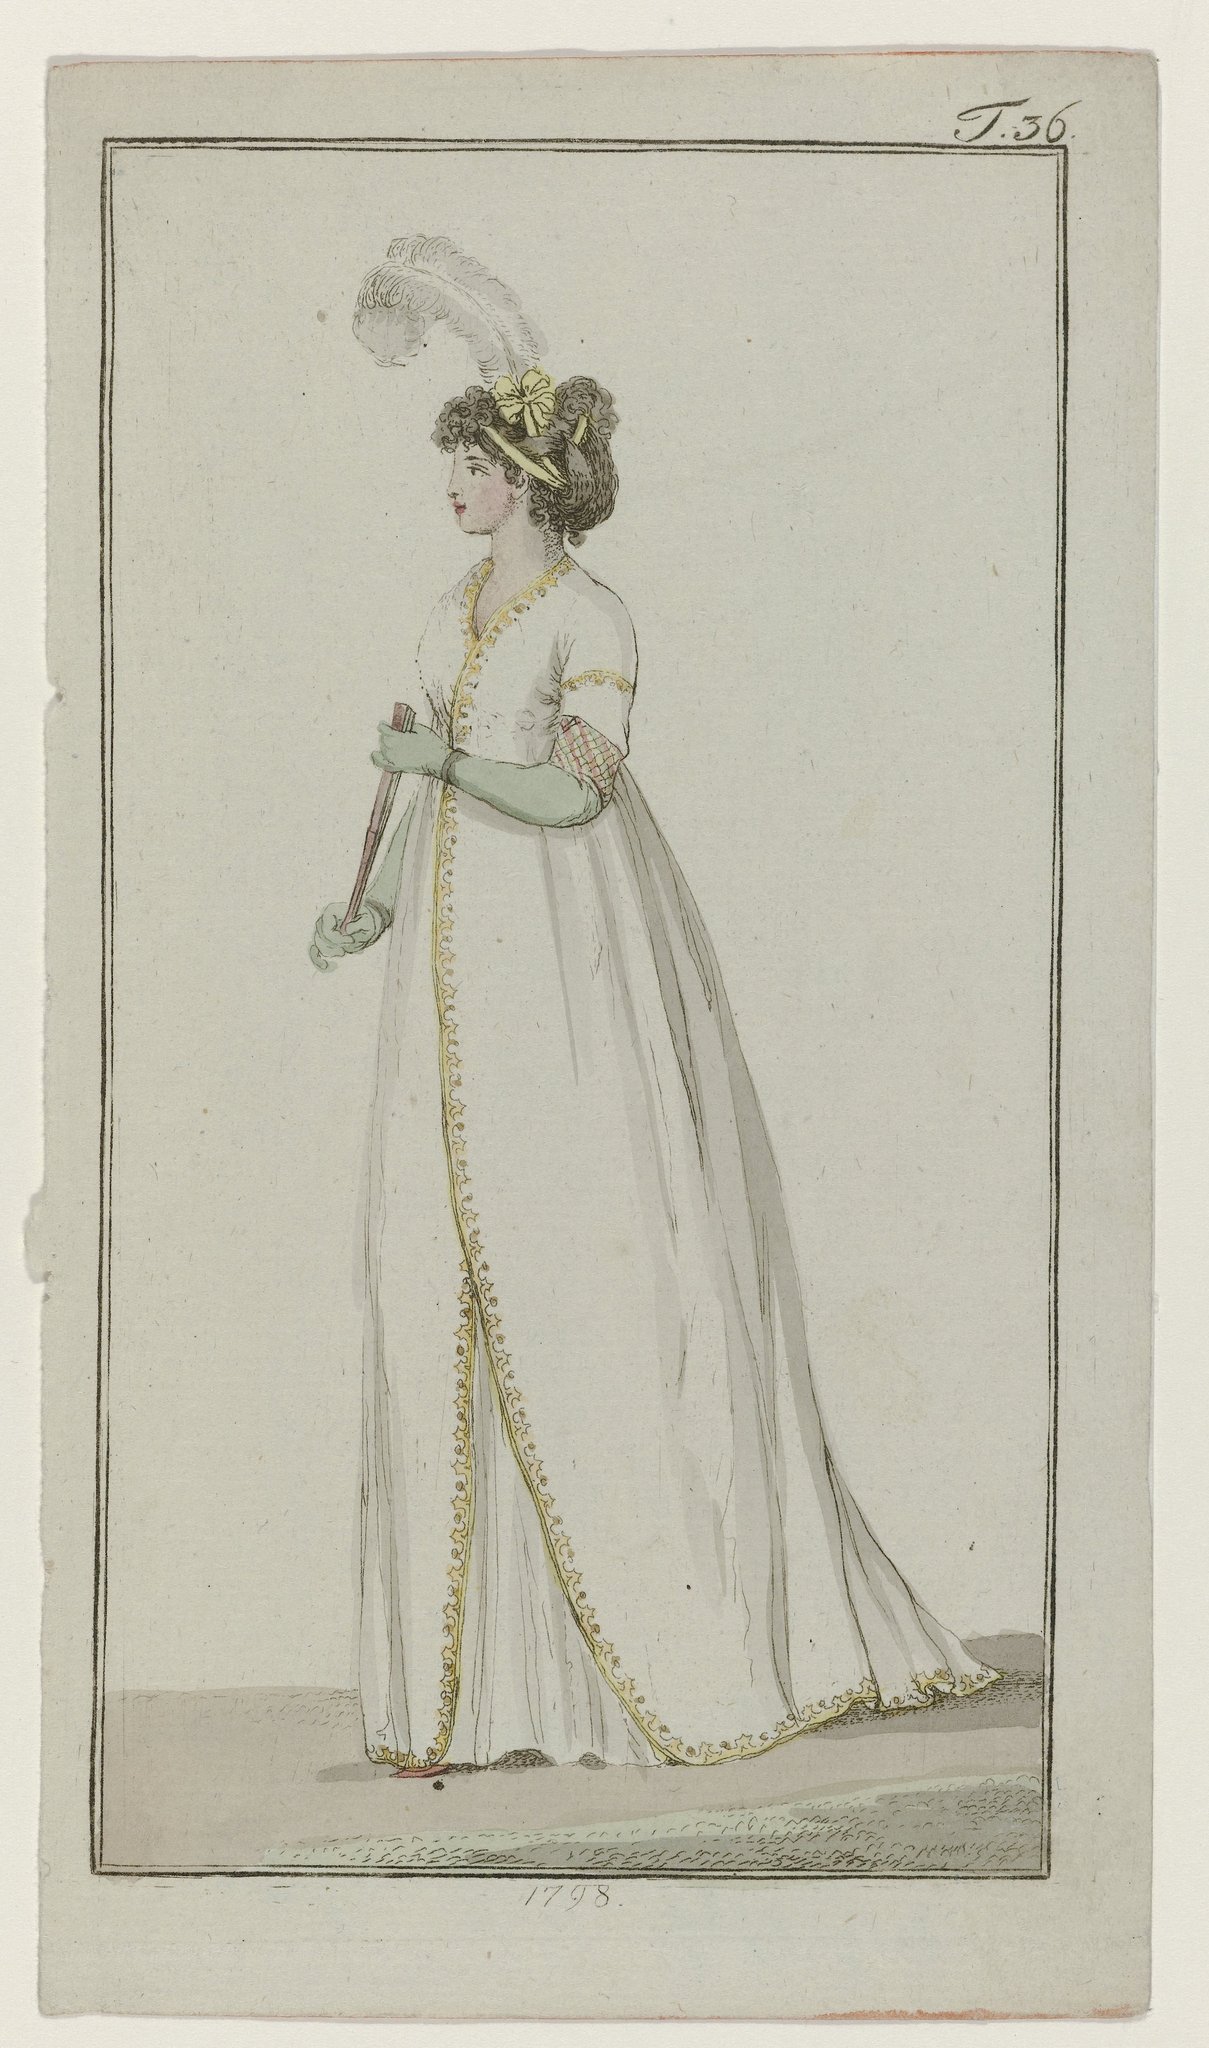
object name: fashion print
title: Journal des Luxus und der Moden, 1798, T 36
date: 1798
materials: paper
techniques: etching, hand coloring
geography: weimar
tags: diadem, tiara (+ women's clothes), gloves, mittens (long gloves) (+ women's clothes), fashion plates, shoes, sandals (+ women's clothes), dress, gown (+ women's clothes), fan (+ women's clothes), bracelet, wristlet (+ women's clothes)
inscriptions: date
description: Vrouw in een japon met overslag, korte mouwen en sleepje, voorzien van sierrand. Het opgestoken haar is versierd met linten, strik en struisveer. Verdere accessoires: lange handschoenen, armbanden om beide polsen, waaier. Prent uit het modetijdschrift Journal des Luxus und der Moden, uitgegeven door Friedrich Justin Bertuch en Georg Melchior Kraus, Weimar, 1786-1826.